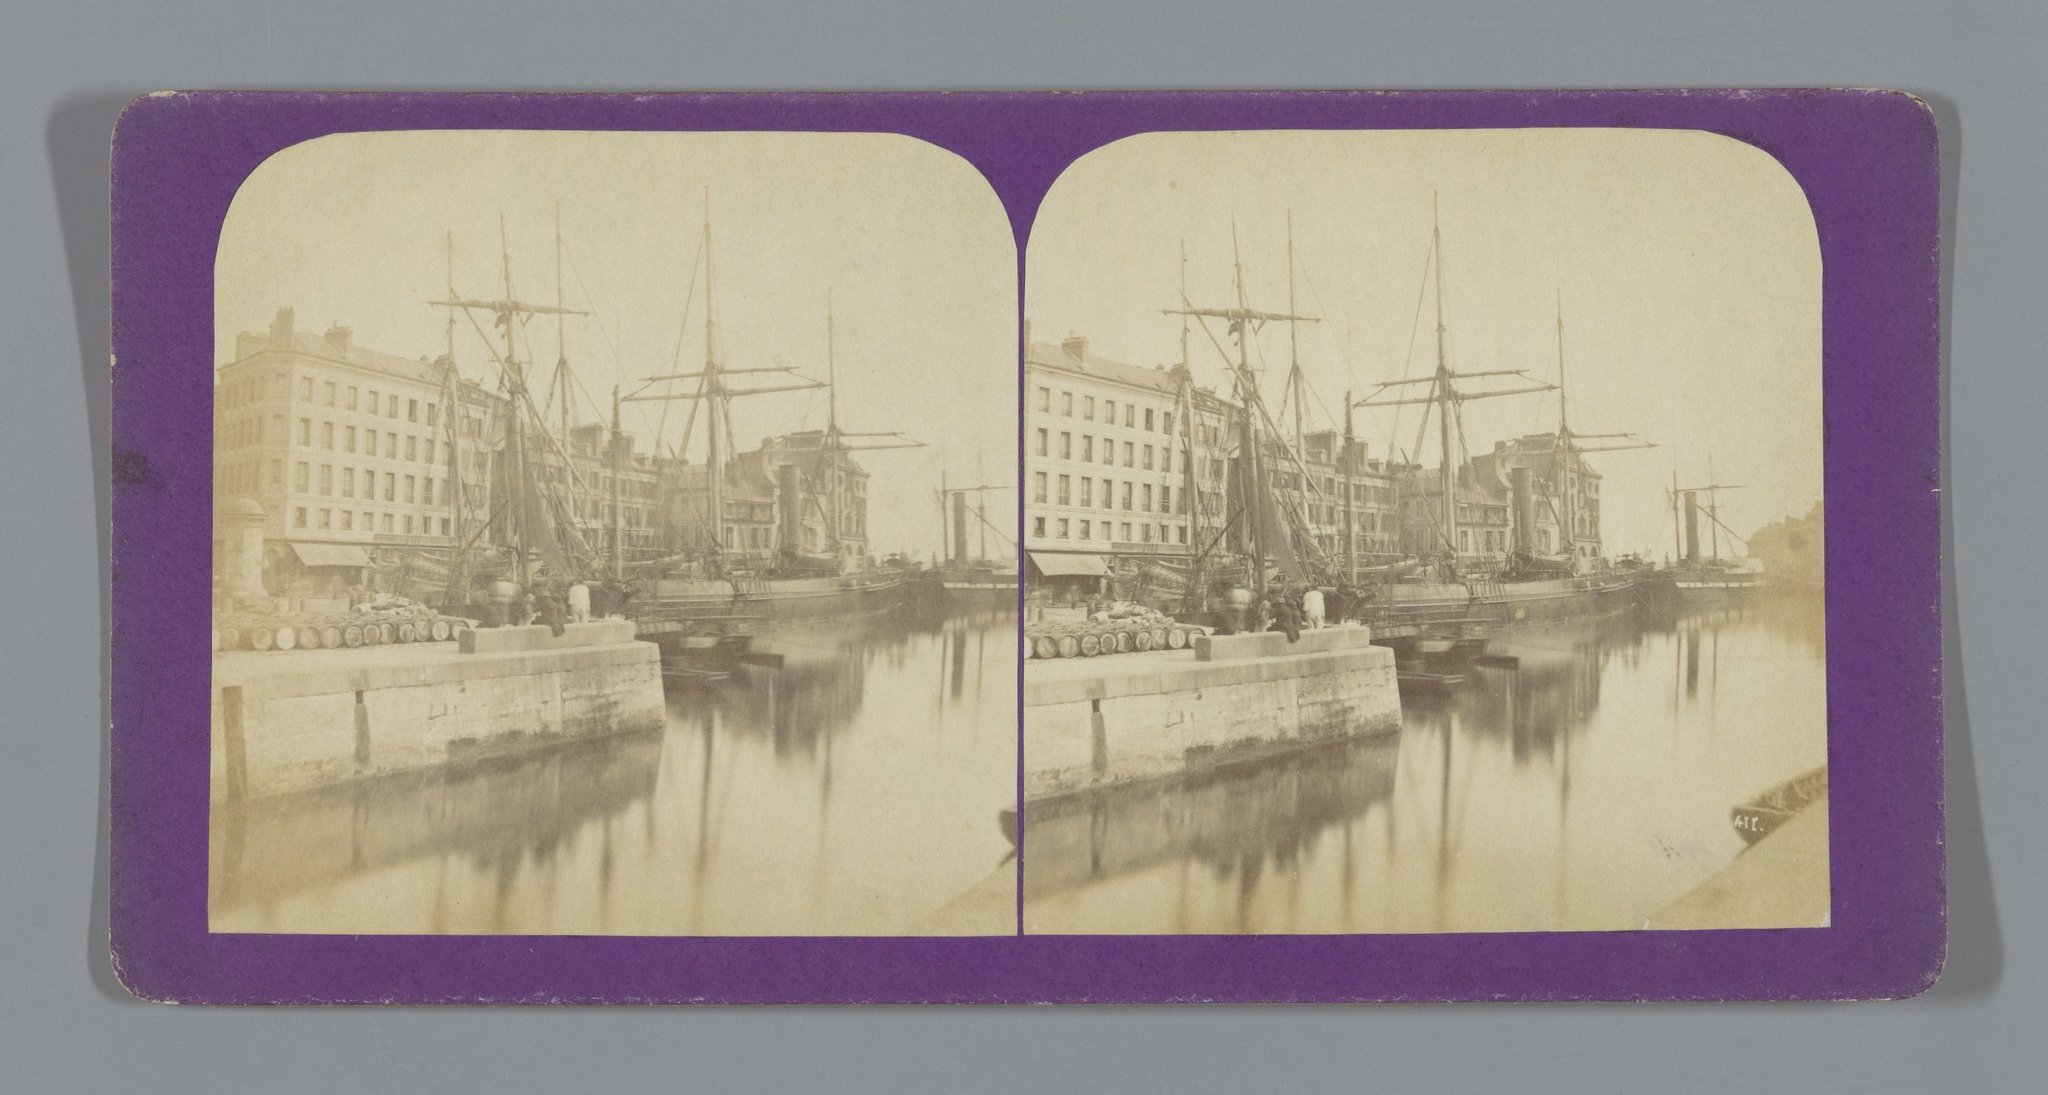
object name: stereograph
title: Schepen in de haven van Le Havre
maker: jean andrieu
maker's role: fotograaf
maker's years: 1816-1872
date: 1862-1876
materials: cardboard, photographic support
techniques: albumen print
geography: le havre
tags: ships (in general), pier, quay, wharf, le havre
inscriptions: inscription: ‘Quai des Casernes, Havre’, number: ‘411.’